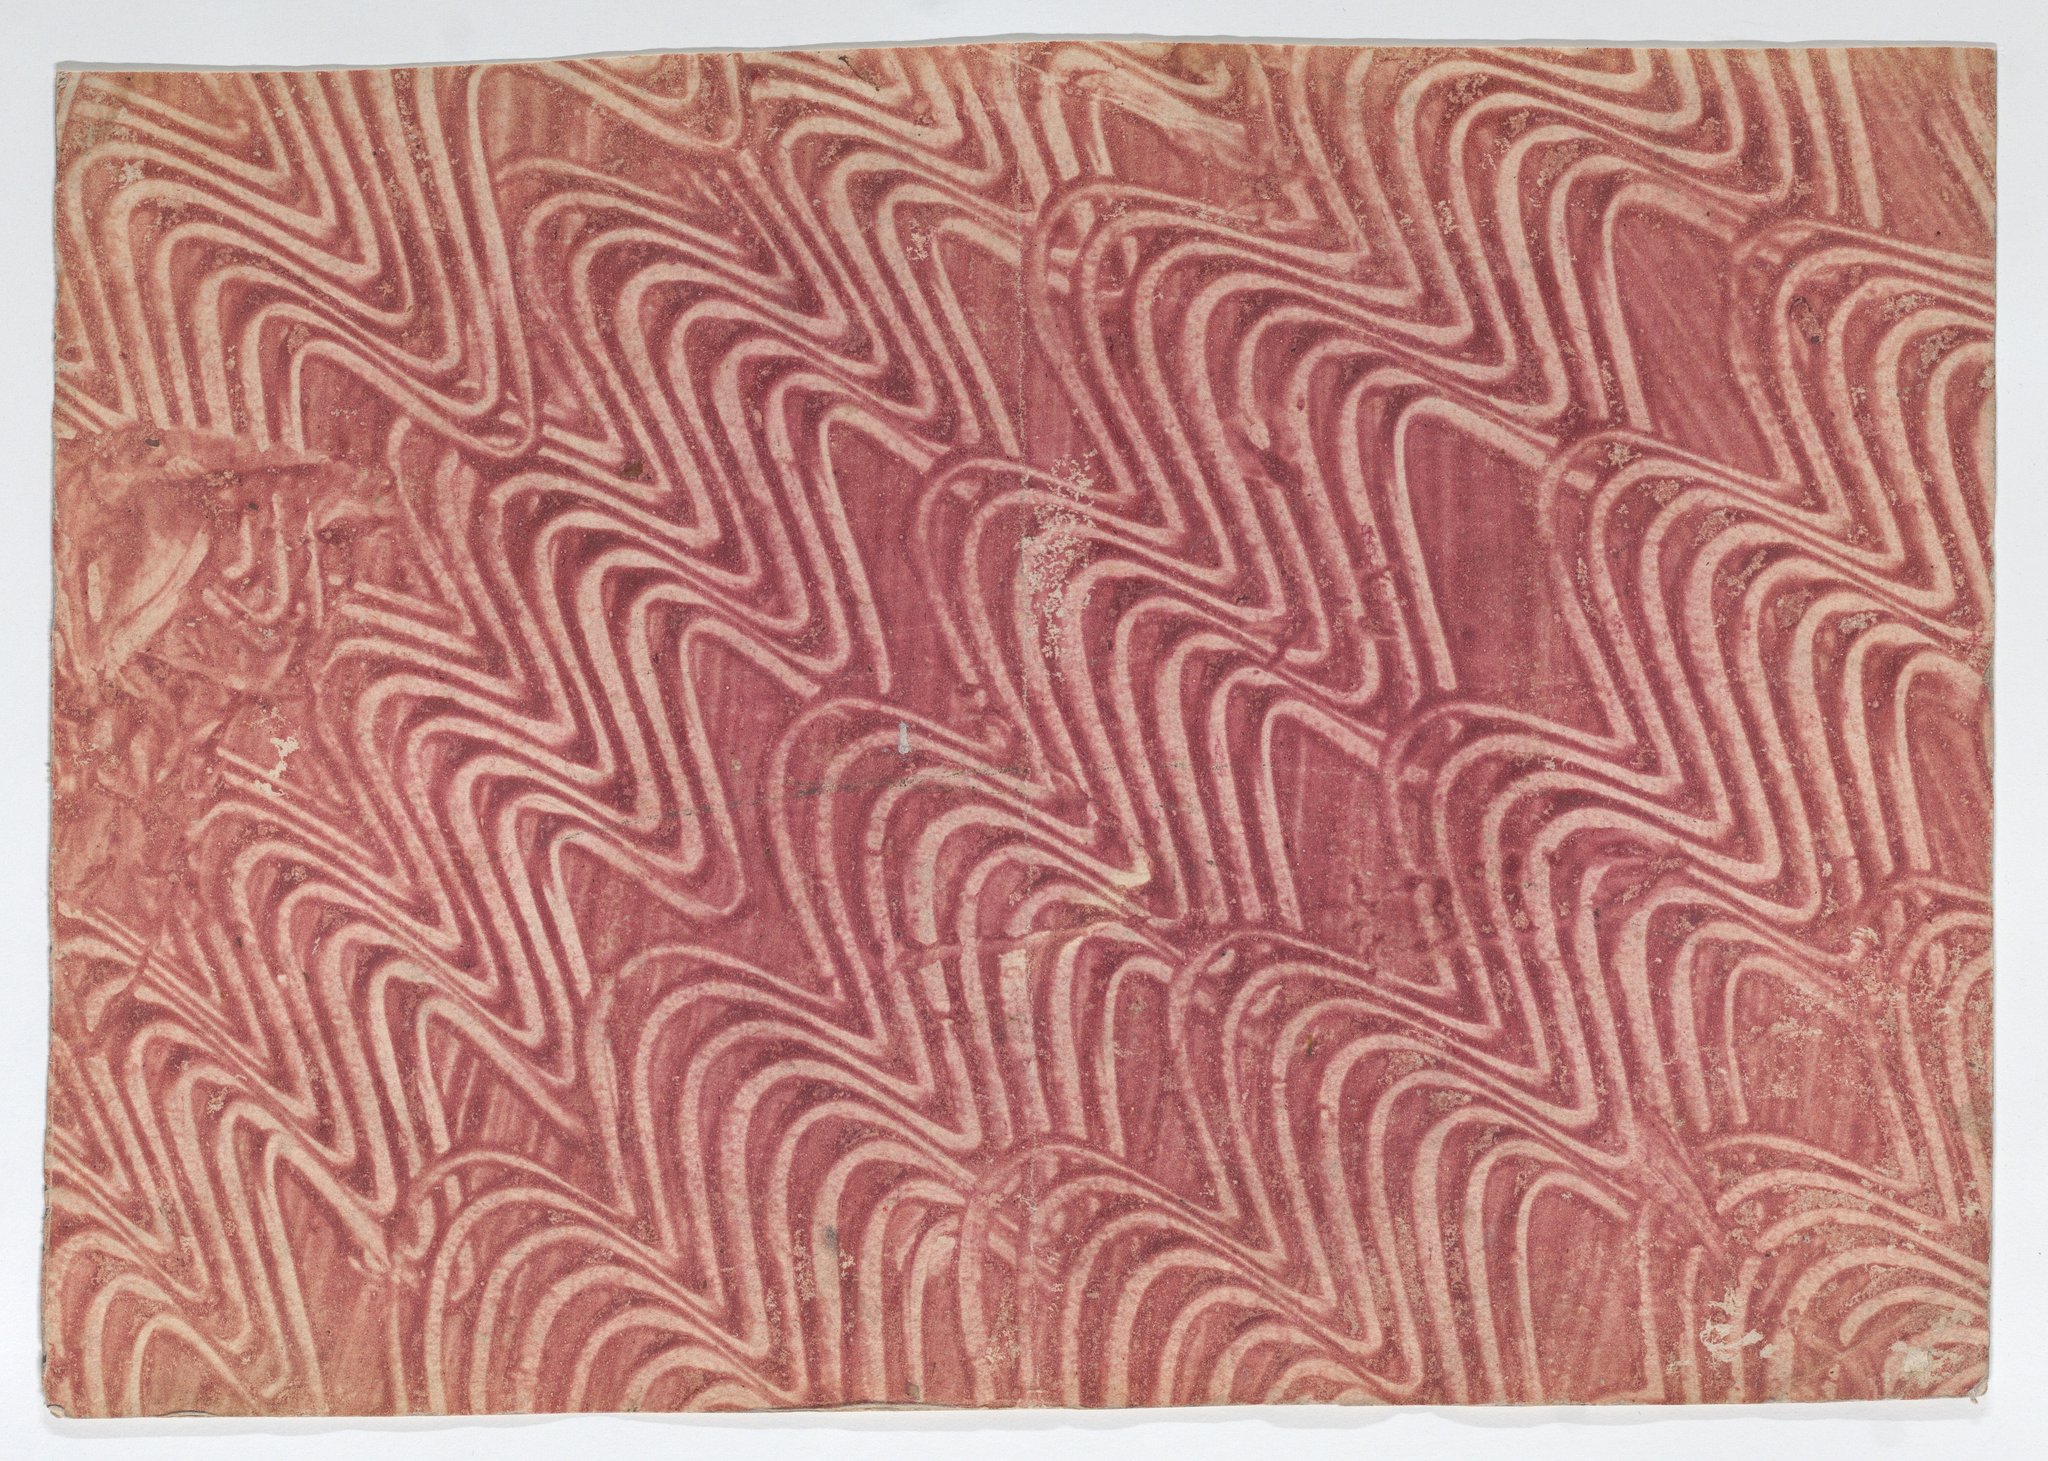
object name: print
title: Red paste book cover with wavy line design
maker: Anonymous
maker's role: artist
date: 1701-1800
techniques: relief print